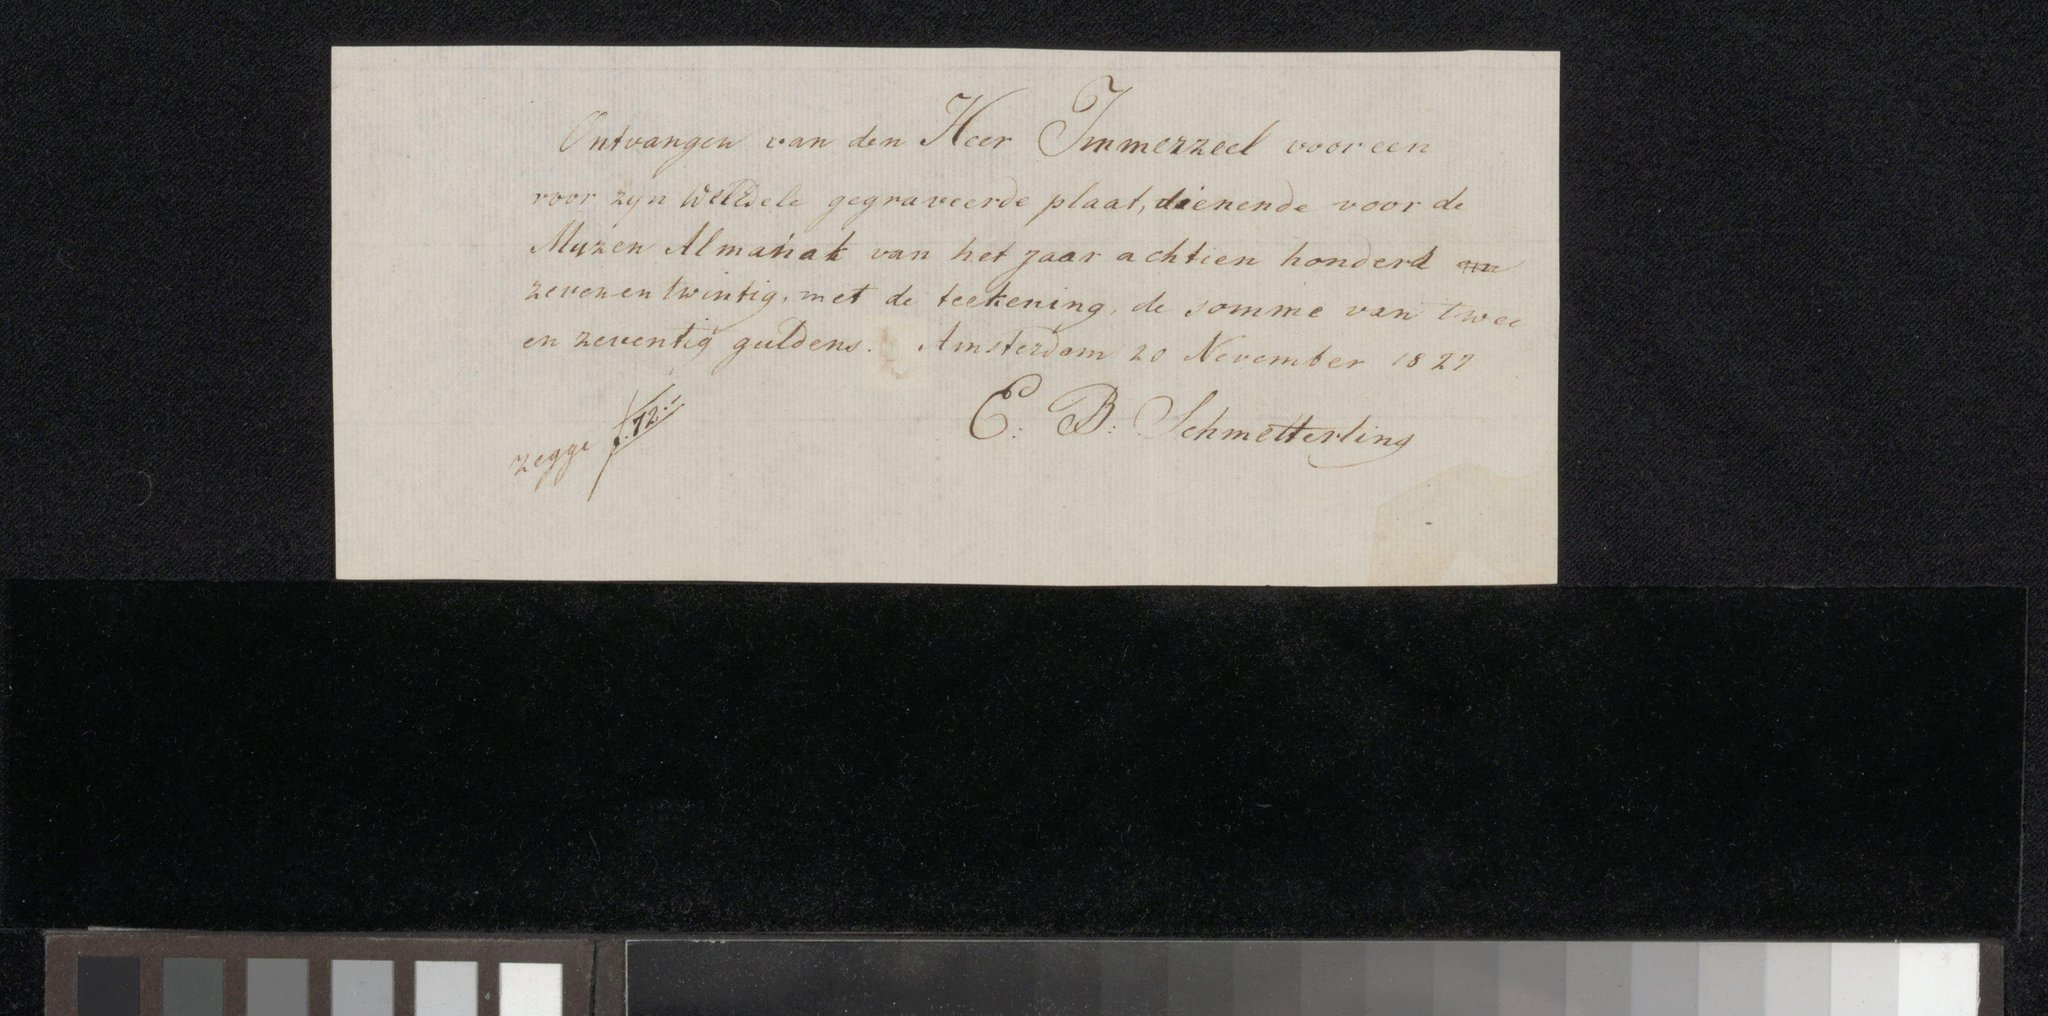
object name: ontvangstbewijs, kwitantie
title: Kwitantie voor Johannes Immerzeel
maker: elisabeth barbara schmetterling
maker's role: draughtsman, print maker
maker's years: 1804-1882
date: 1827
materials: ink, paper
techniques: pen, writing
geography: amsterdam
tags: johannes immerzeel, drawing, the graphic arts, money